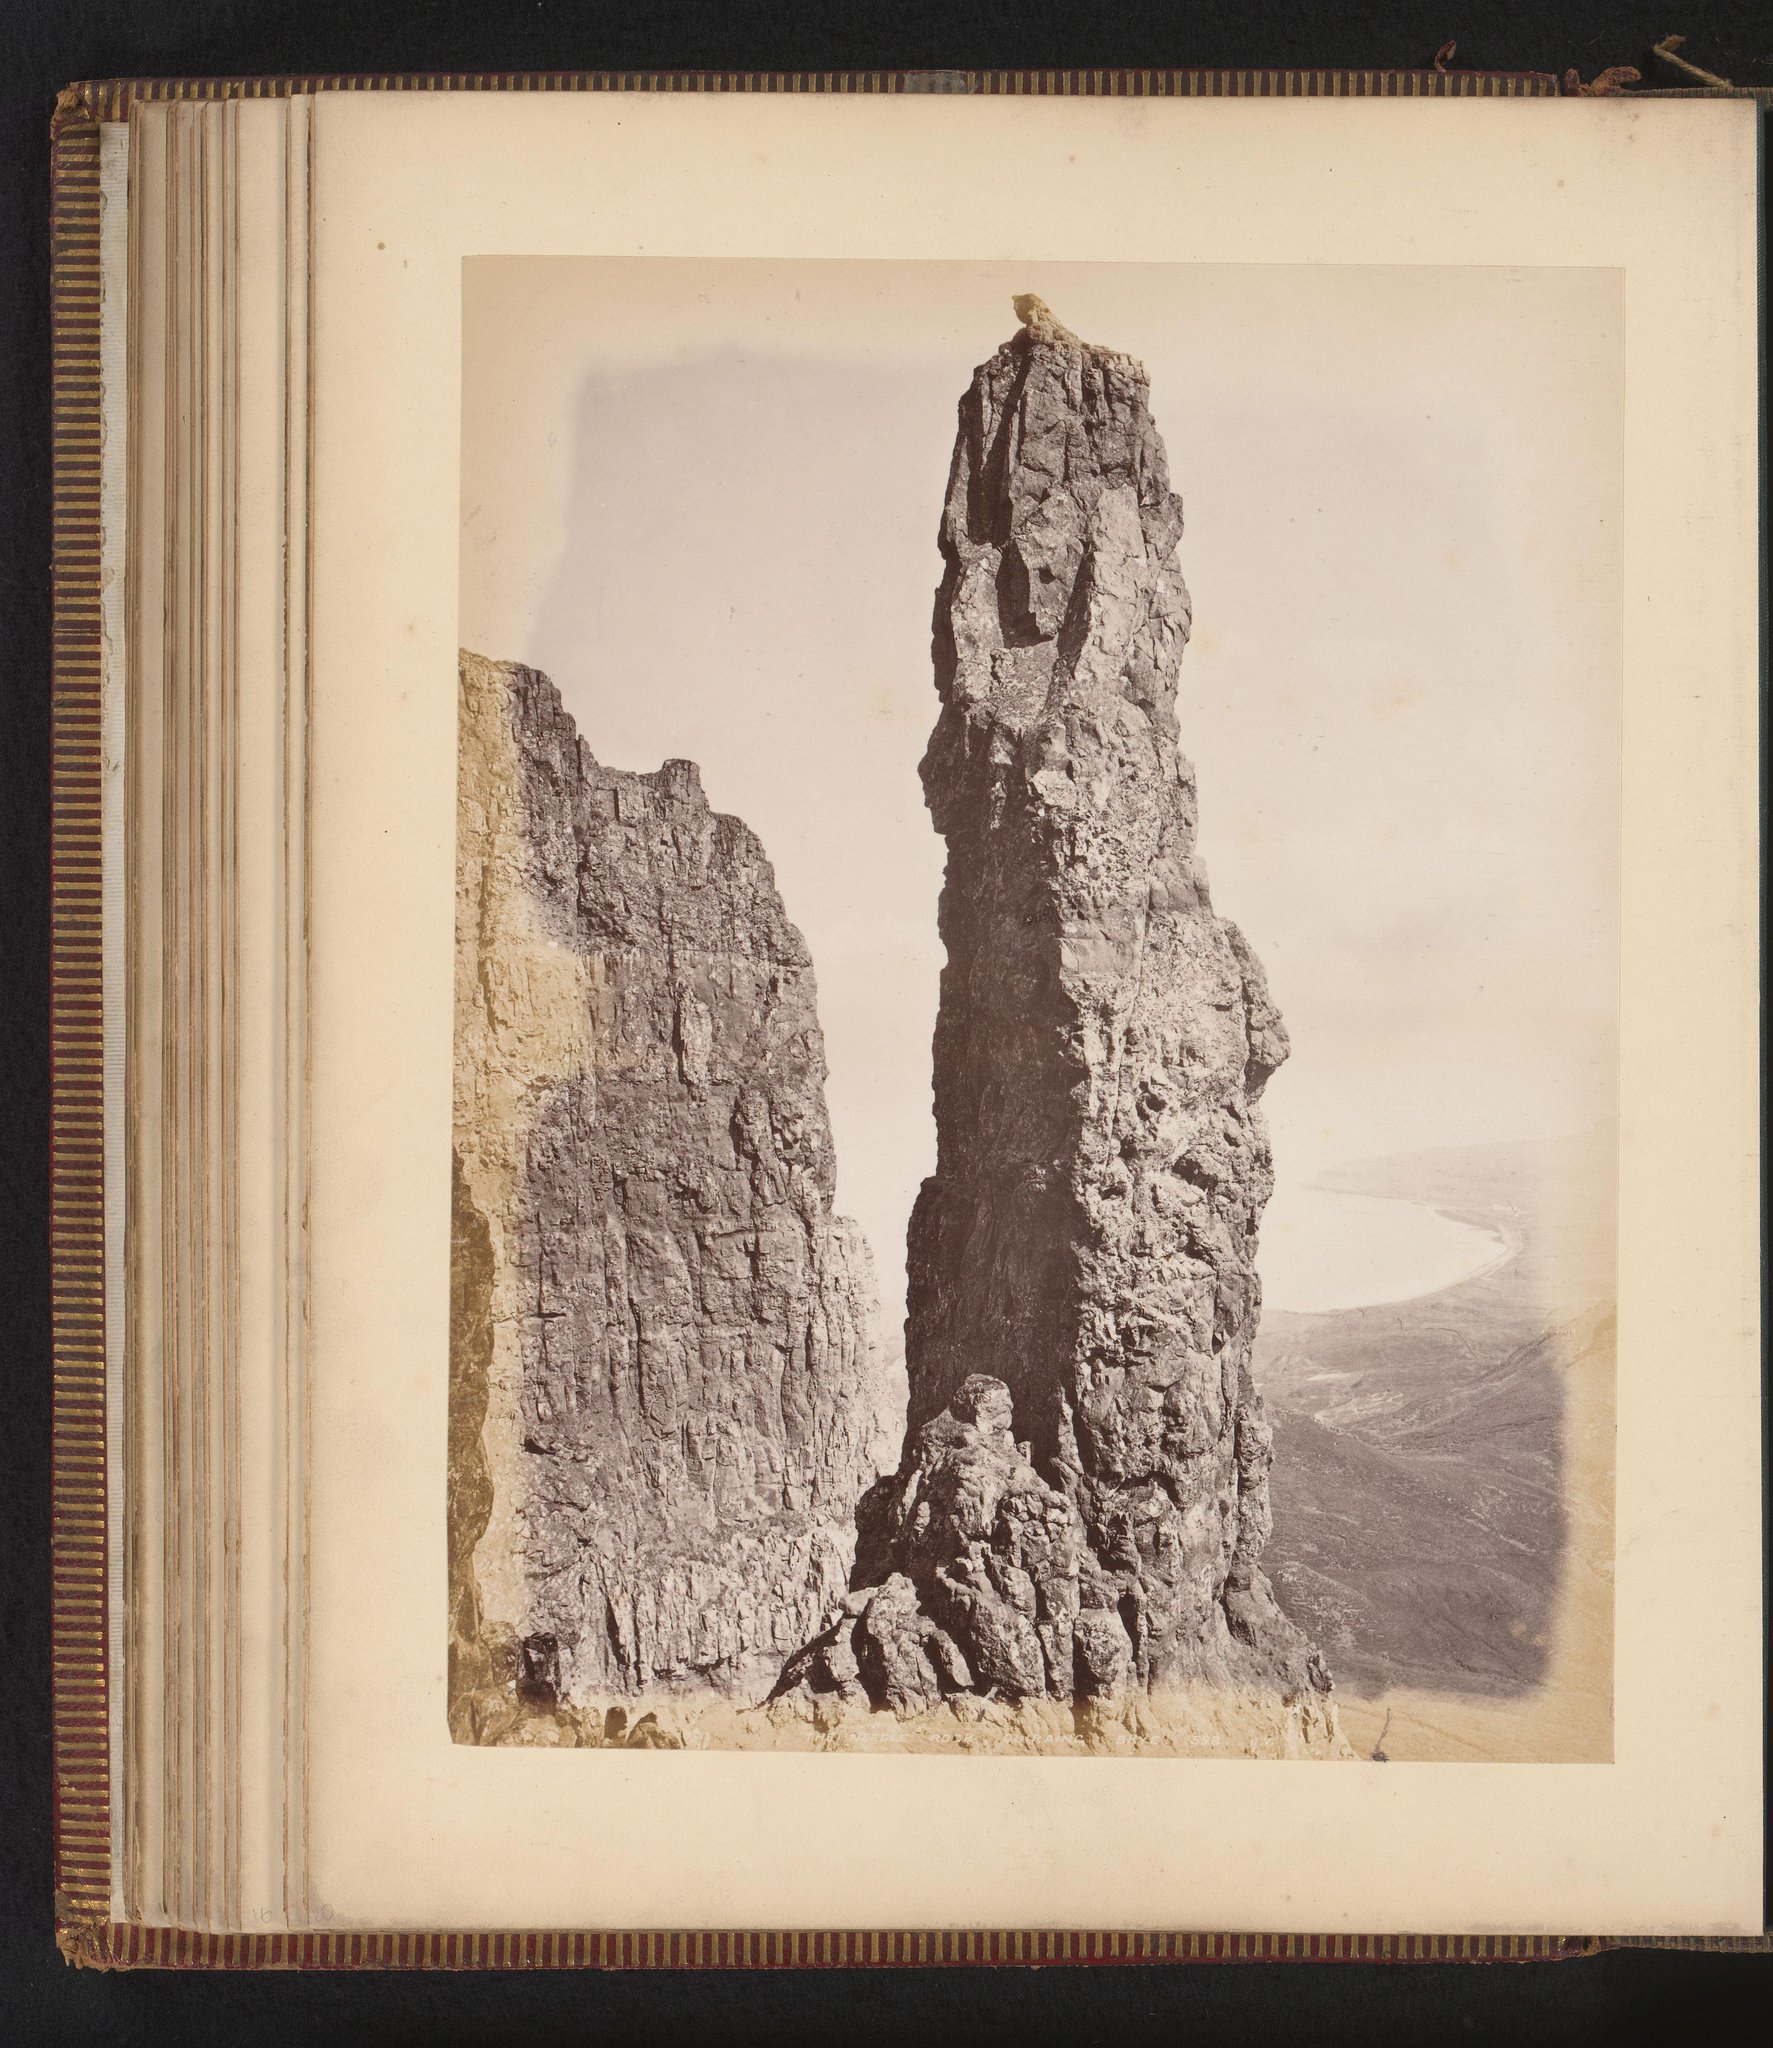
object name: photograph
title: The Needle Rock, Duirainc, Skye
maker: Anonymous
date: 1875-1885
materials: photographic support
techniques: albumen print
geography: skye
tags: rock-formations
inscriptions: number: ‘598, J.V.’